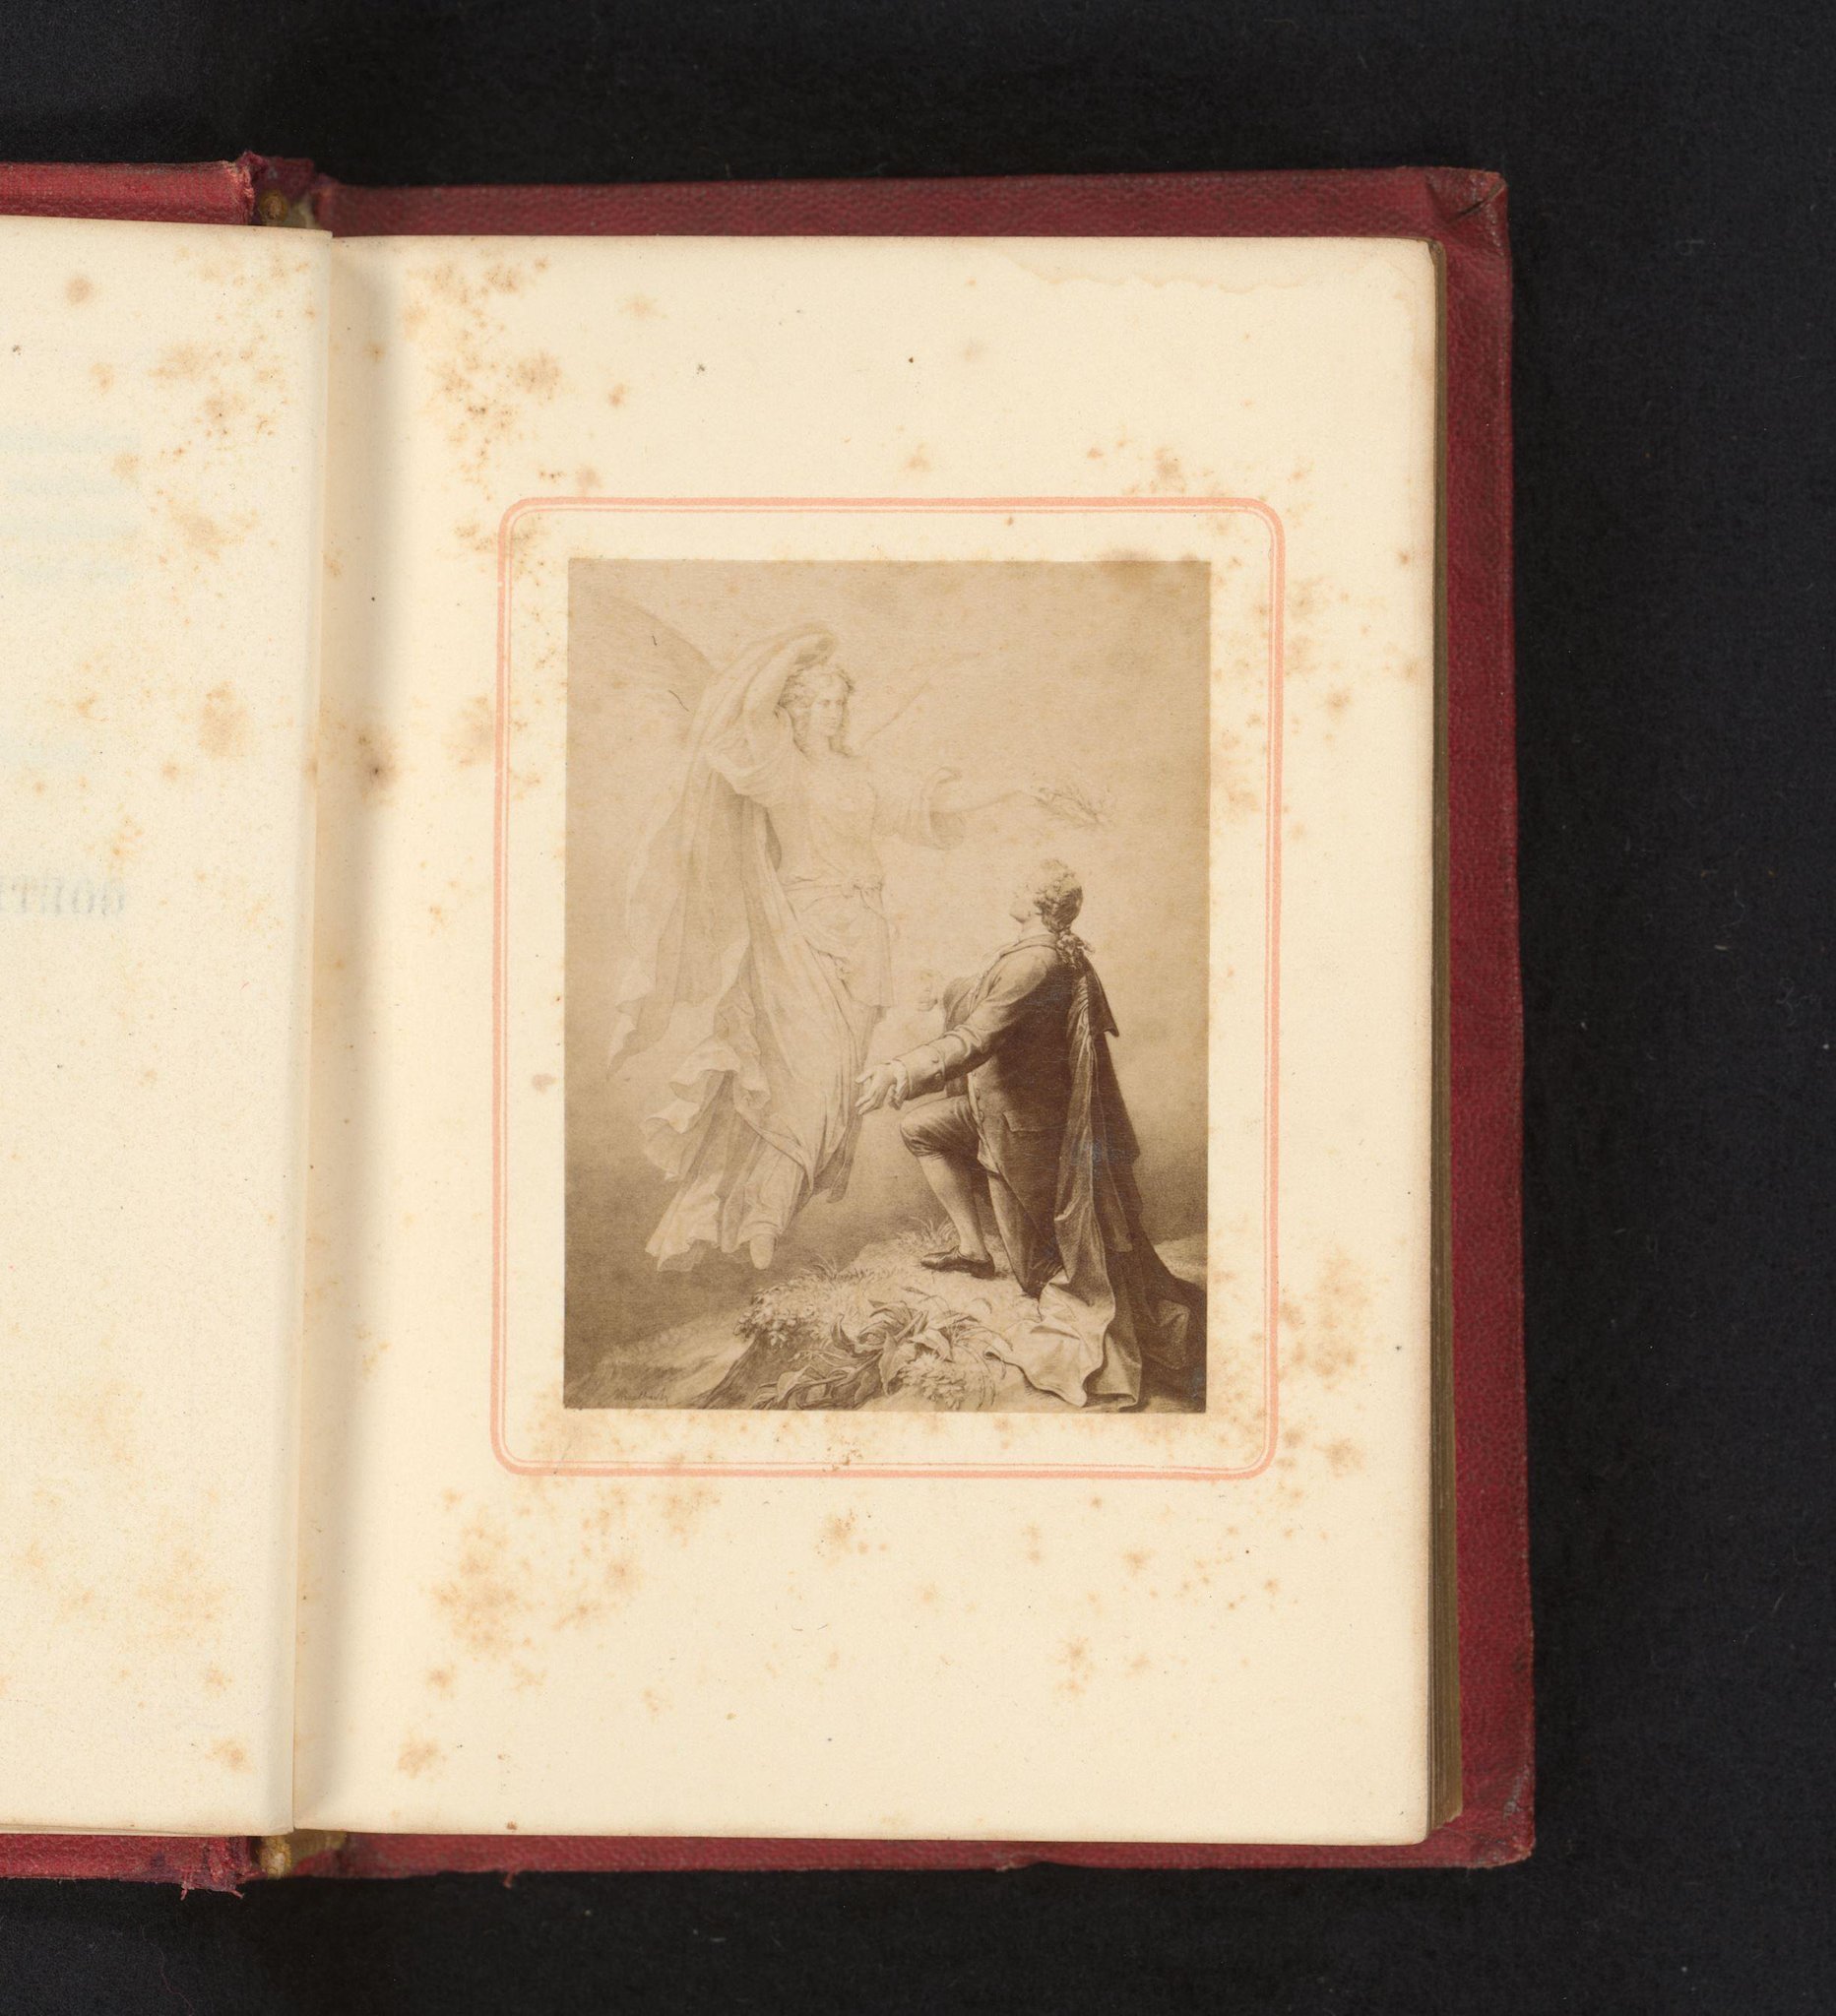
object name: photograph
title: Fotoreproductie van de tekening Goethe und die Muse door Wilhelm von Kaulbach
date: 1863-1870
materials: paper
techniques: albumen print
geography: munich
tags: draughtsman, johann wolfgang von goethe, drawing, sketch